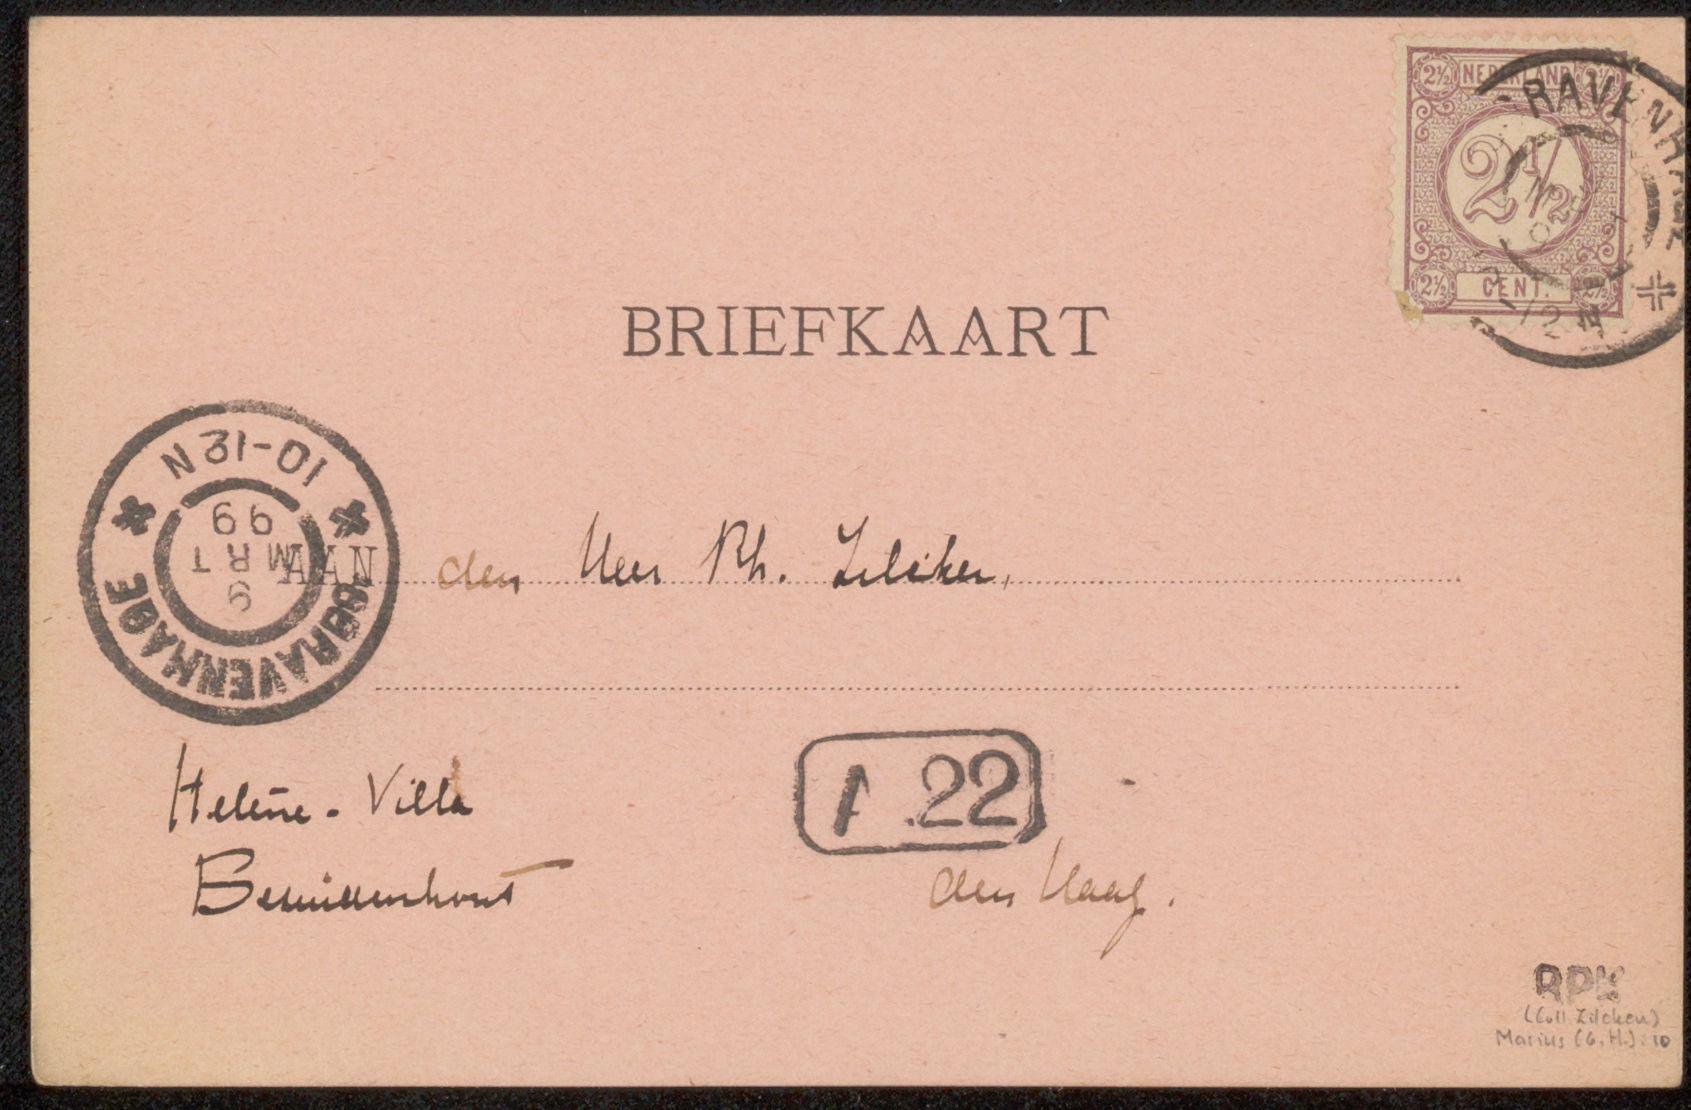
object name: postcard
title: Briefkaart aan Philip Zilcken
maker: grada hermina marius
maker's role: painter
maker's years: 1854-1919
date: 1899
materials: cardboard, ink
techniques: pen, writing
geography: the hague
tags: london, print maker, draughtsman, matthijs maris, philip zilcken, printed matter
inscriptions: collector's mark: ‘RPK’